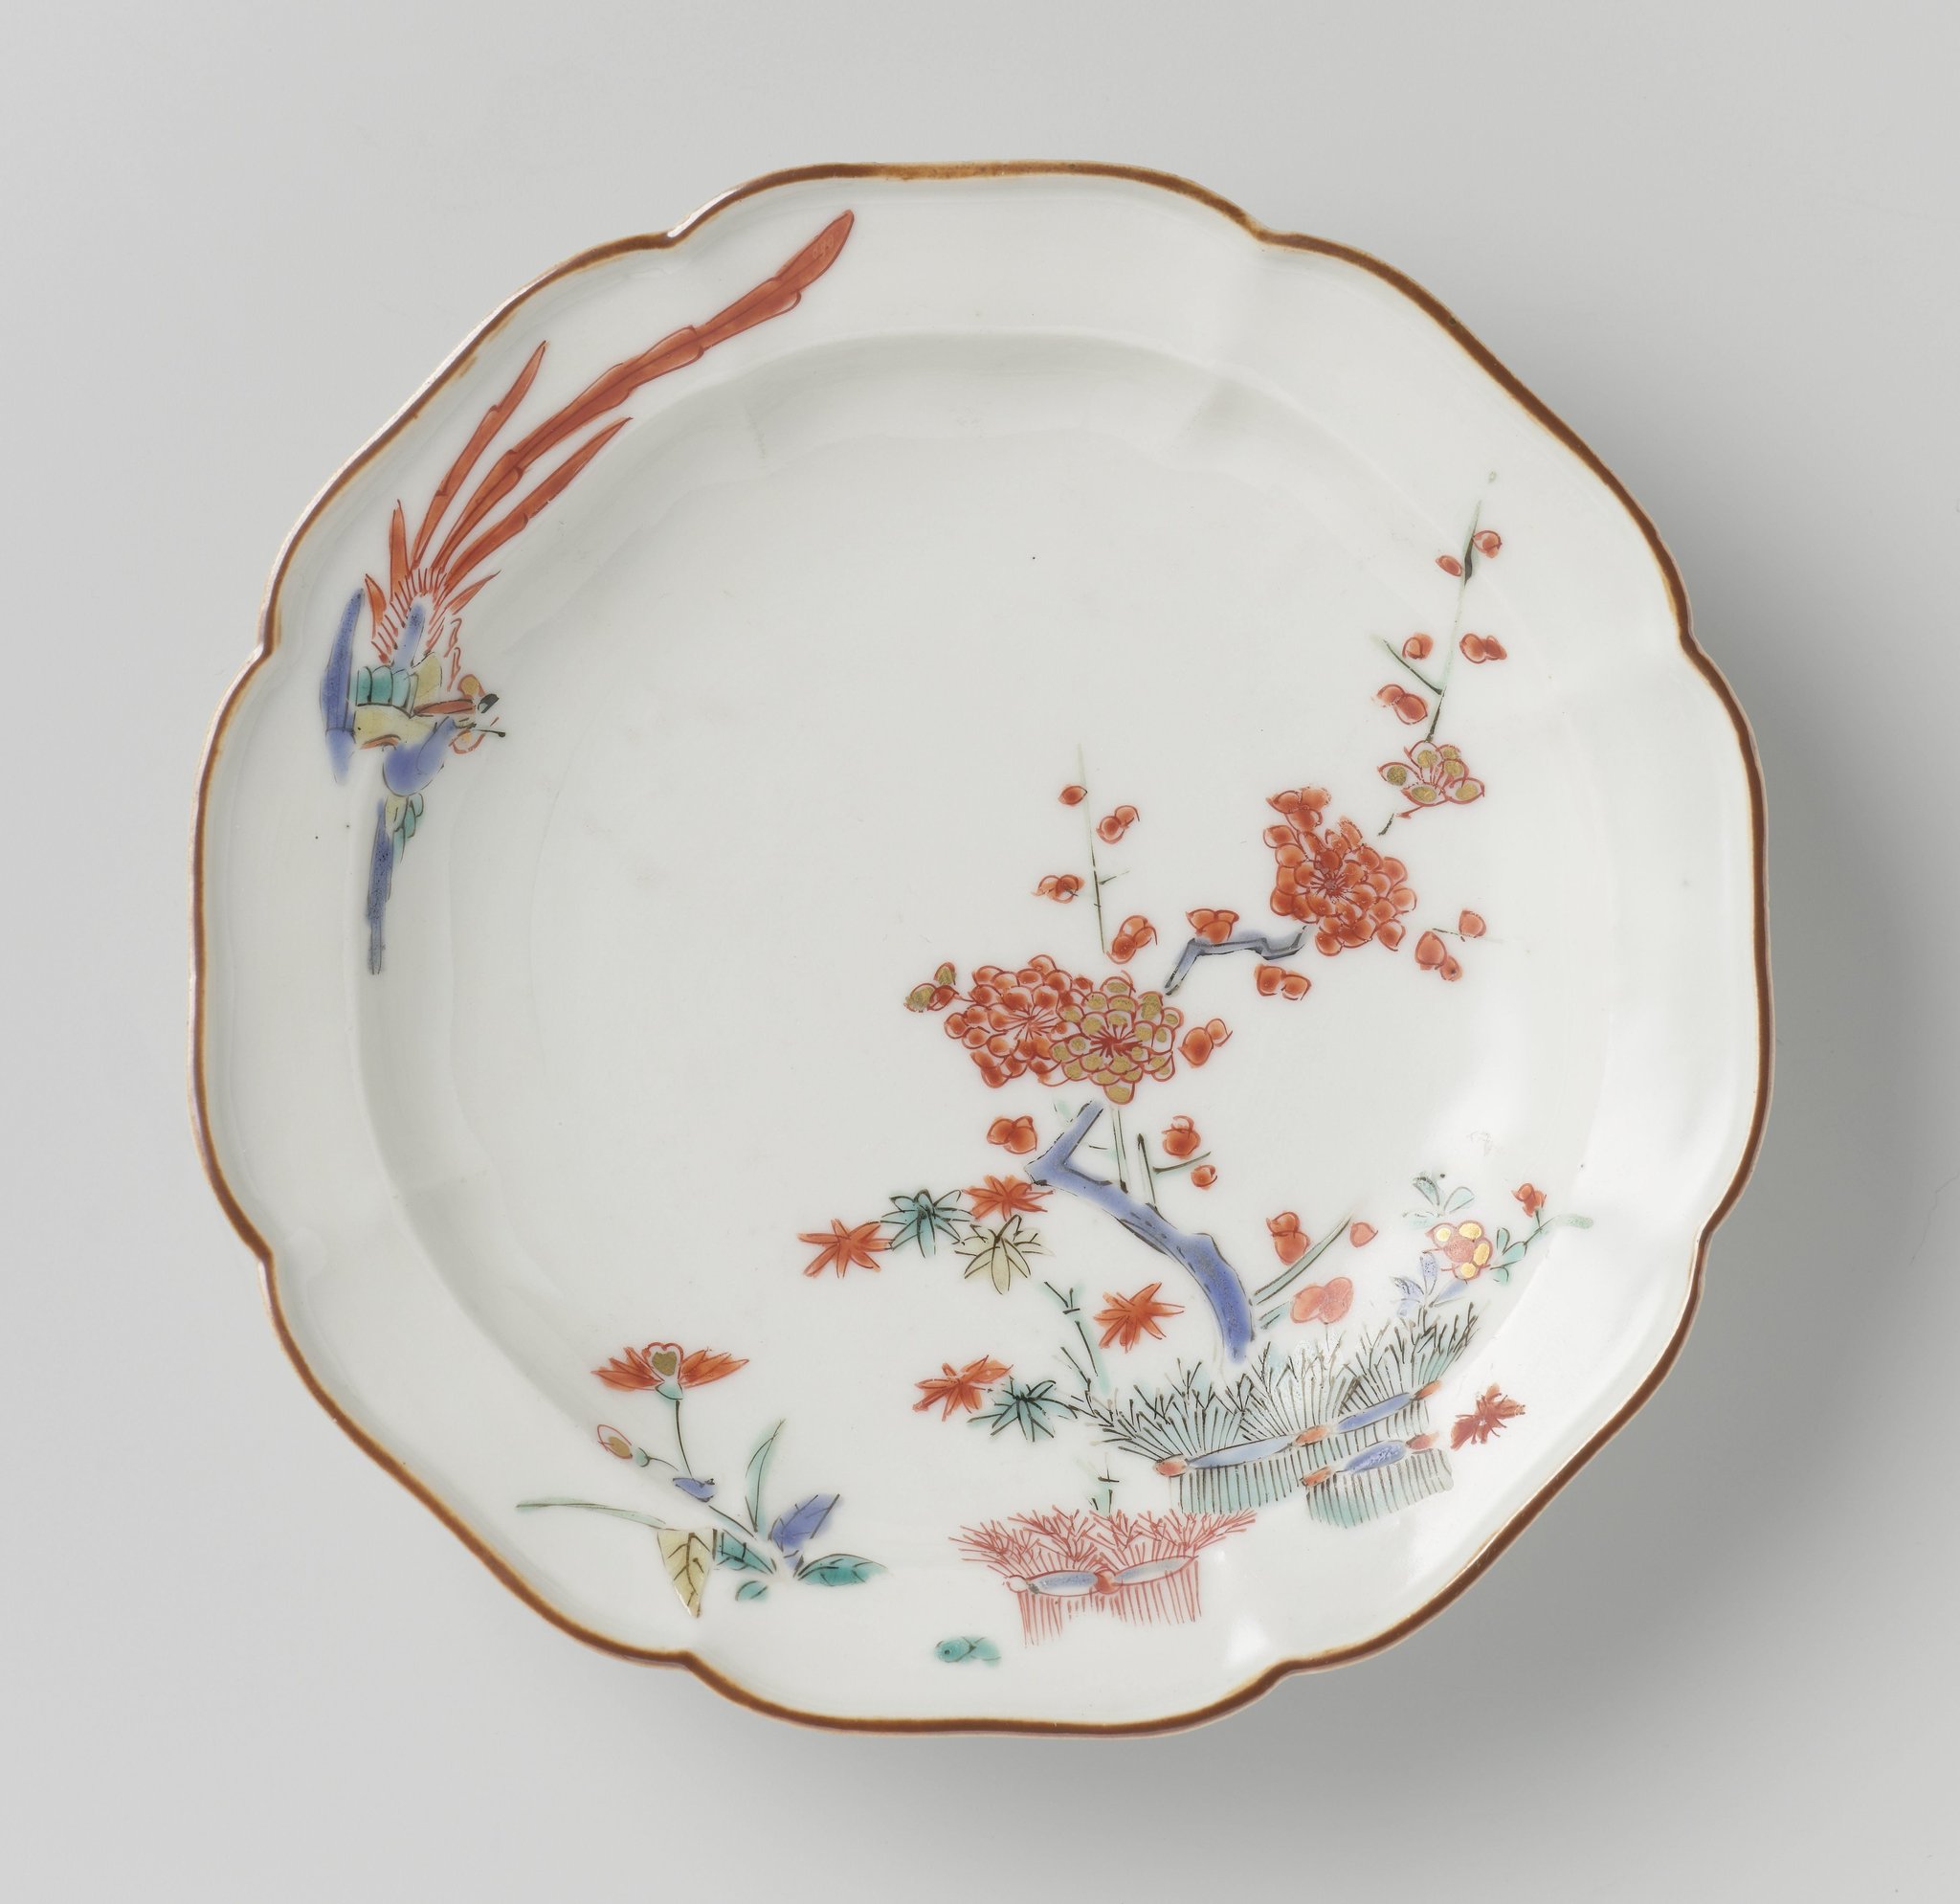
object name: plate dish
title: Scalloped dish with hedges, bamboo, prunus and hoo-bird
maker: Anonymous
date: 1670-1690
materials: glaze, gold, paint, porcelain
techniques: firing, gilding, turning, vitrification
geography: japan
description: Cup and saucer, c. 1700 - 1725.